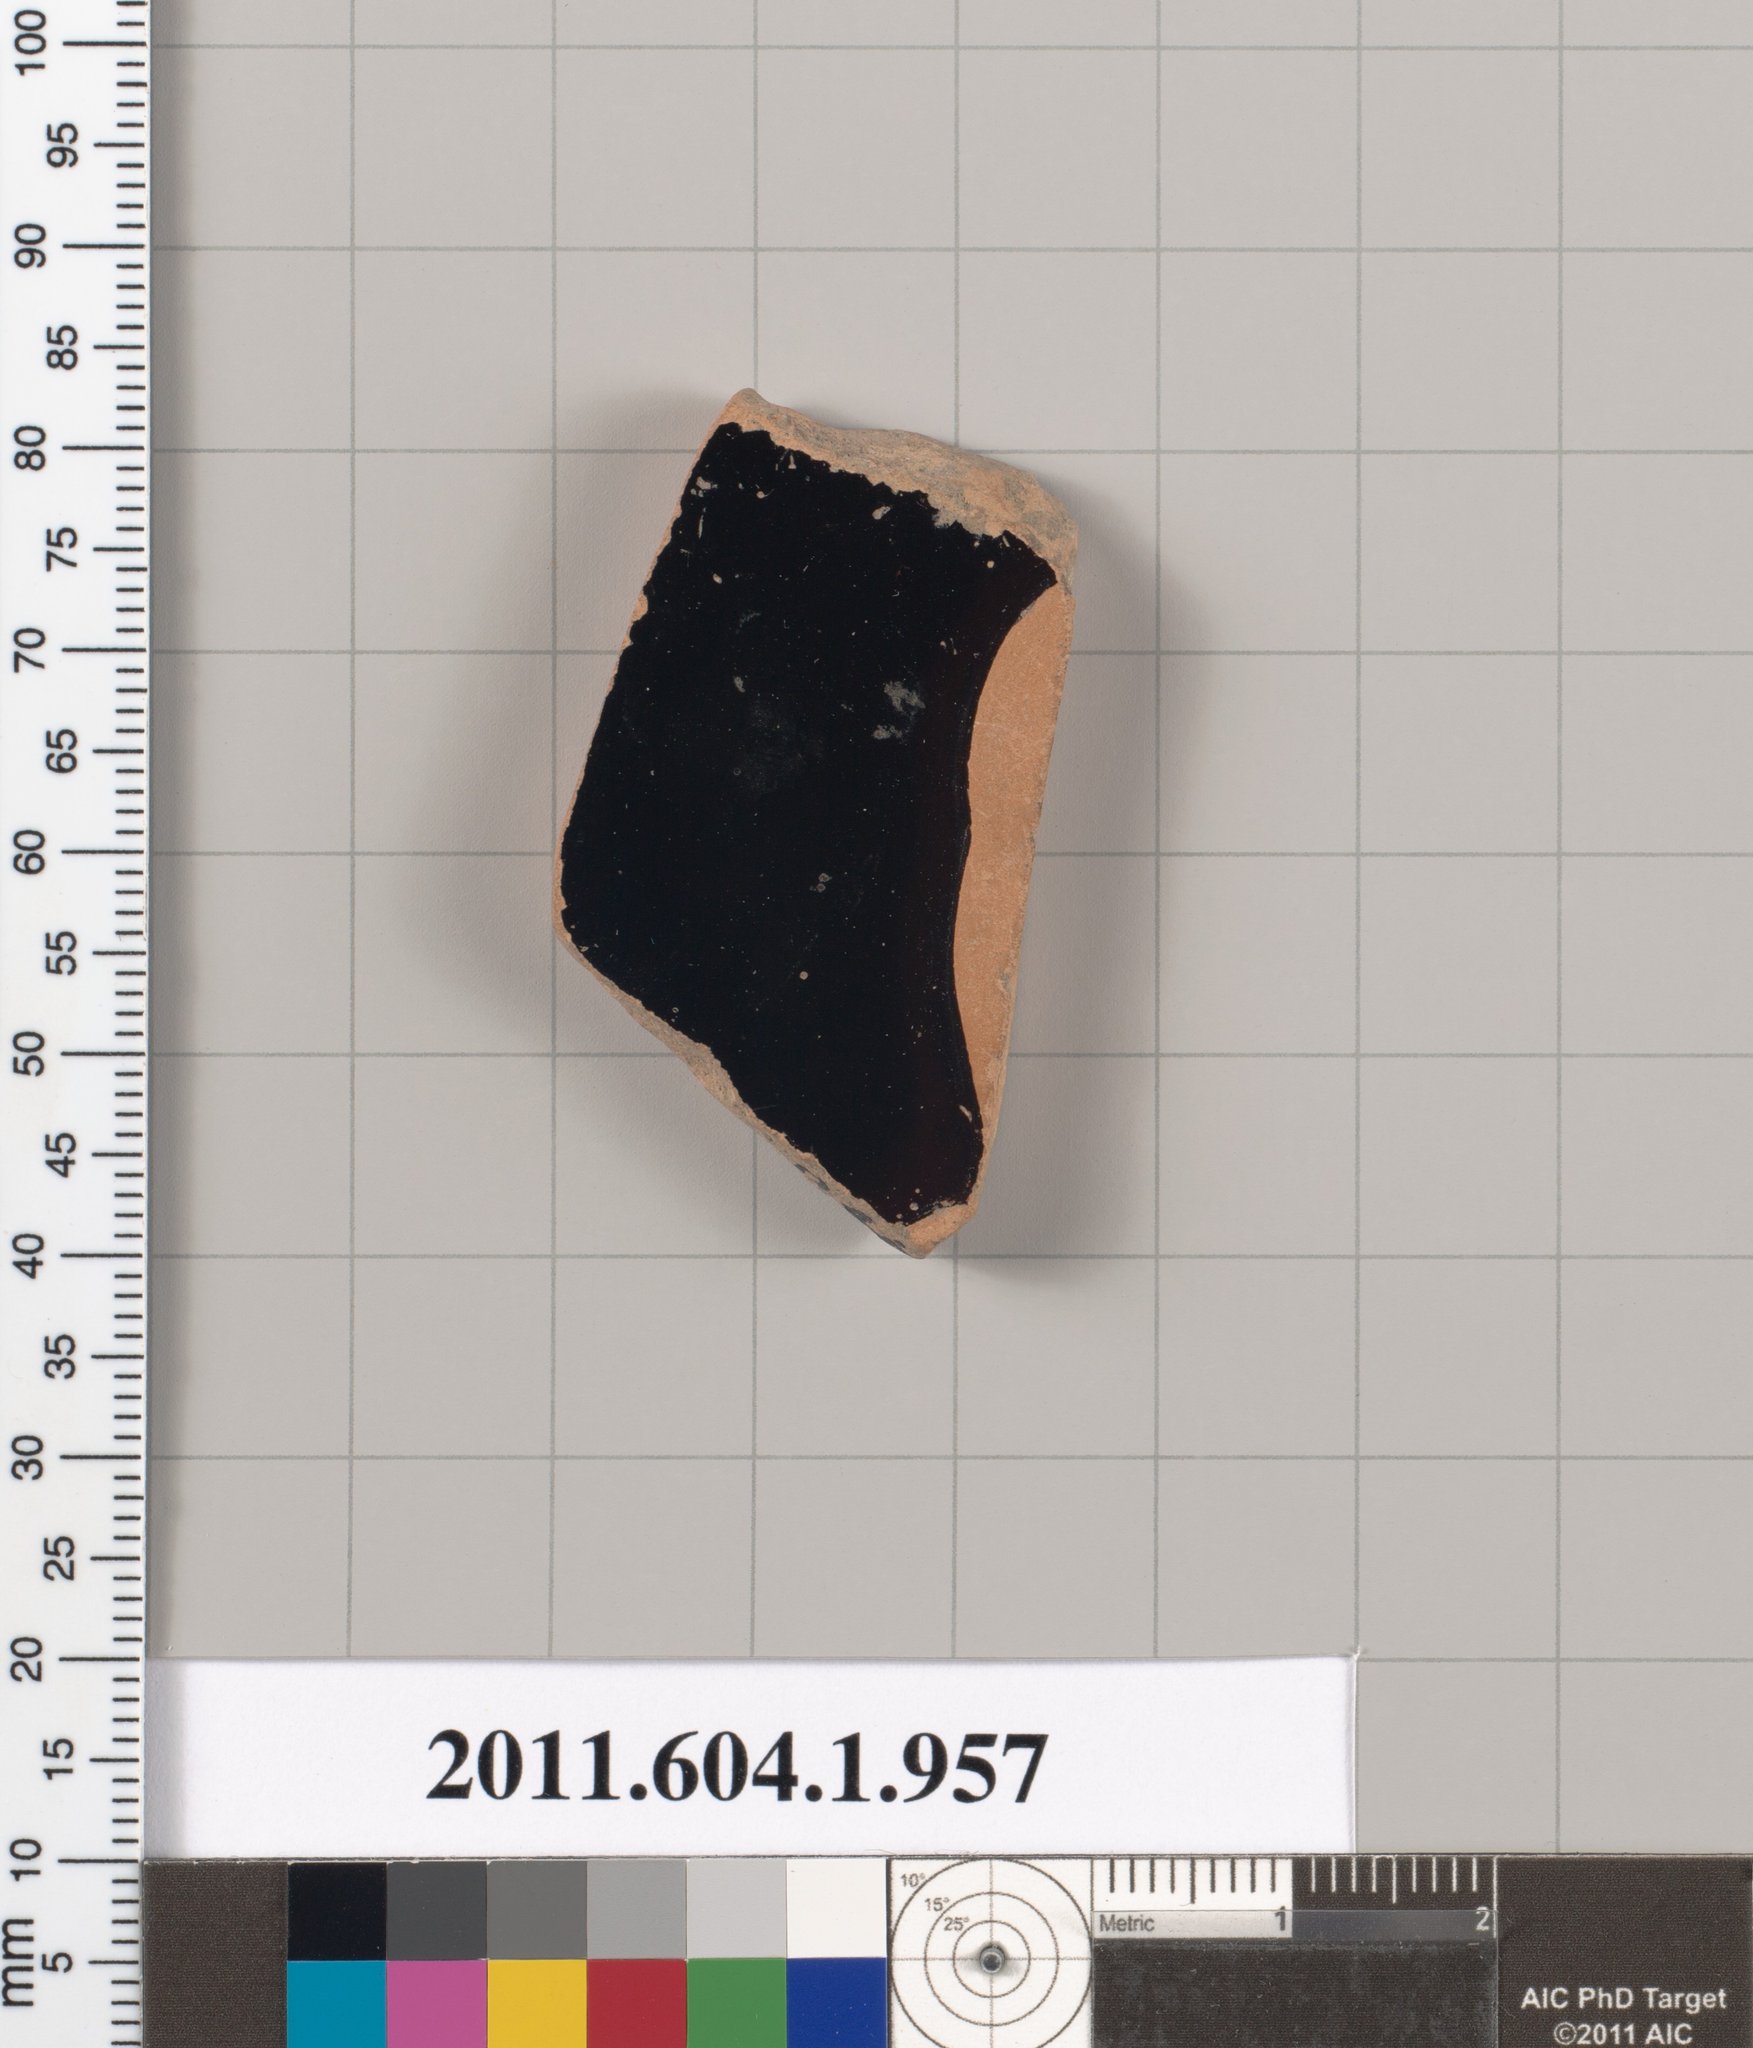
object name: kylix fragment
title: Terracotta fragment of a kylix (drinking cup)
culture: greek, attic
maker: makron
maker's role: artist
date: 490-480 BCE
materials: terracotta